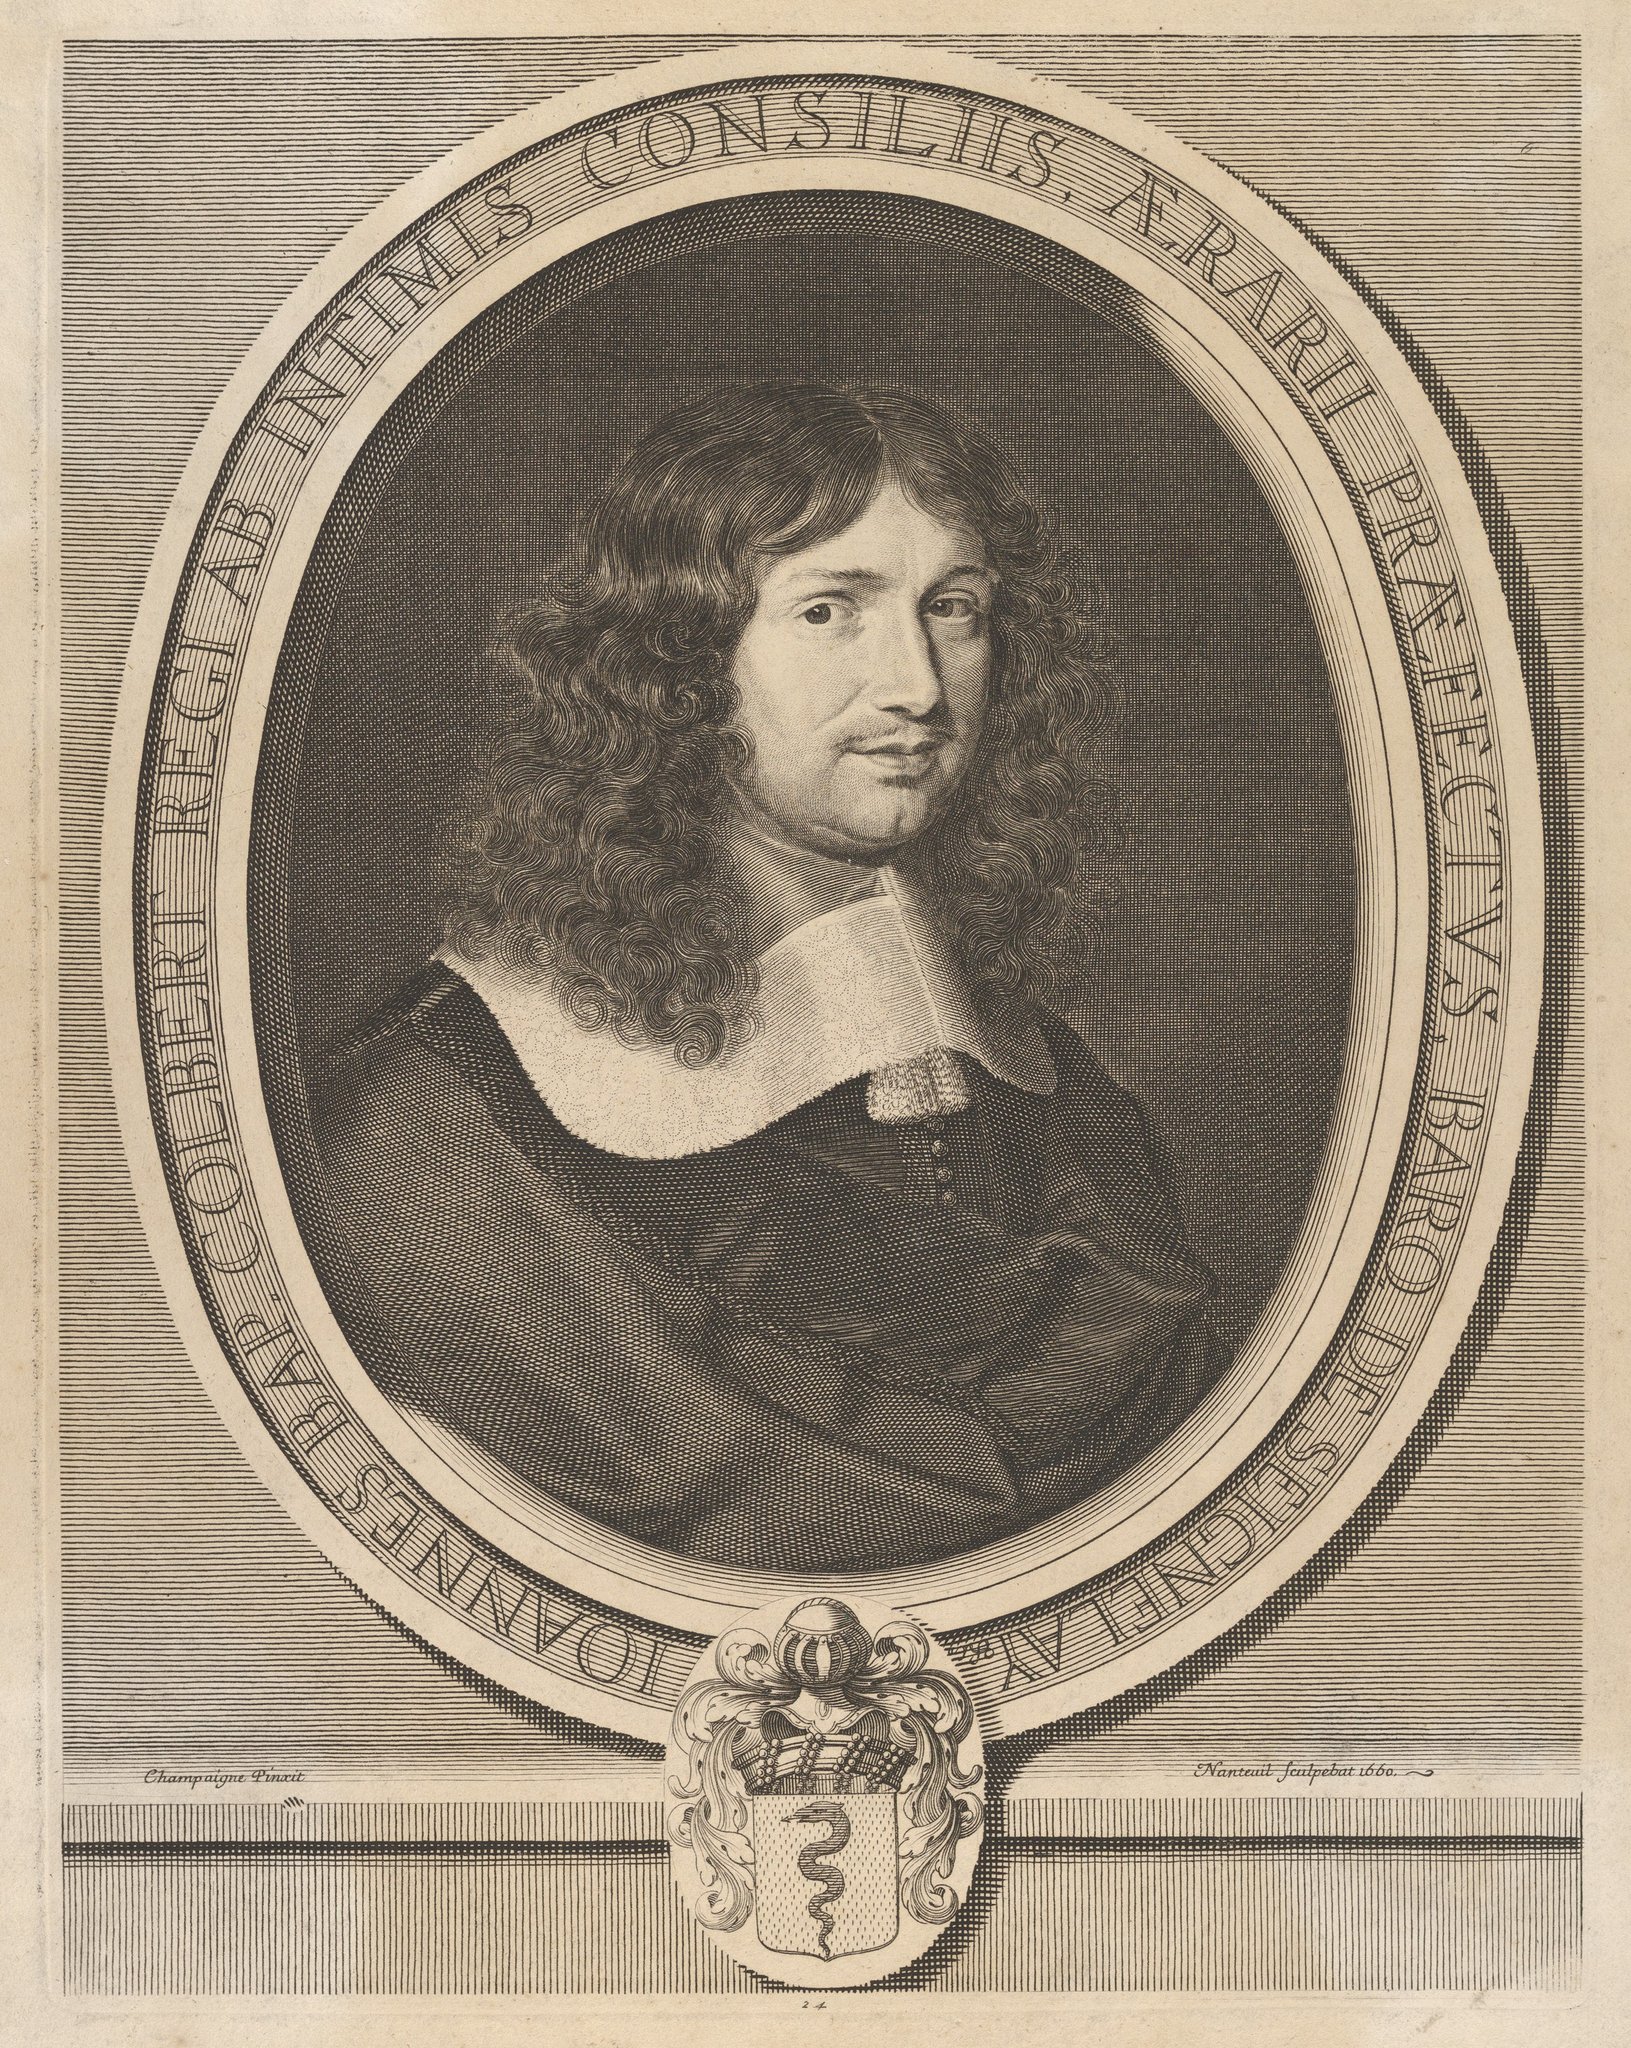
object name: print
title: Jean-Baptiste Colbert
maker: robert nanteuil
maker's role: artist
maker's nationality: french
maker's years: 1623-1678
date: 1666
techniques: engraving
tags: men,portraits